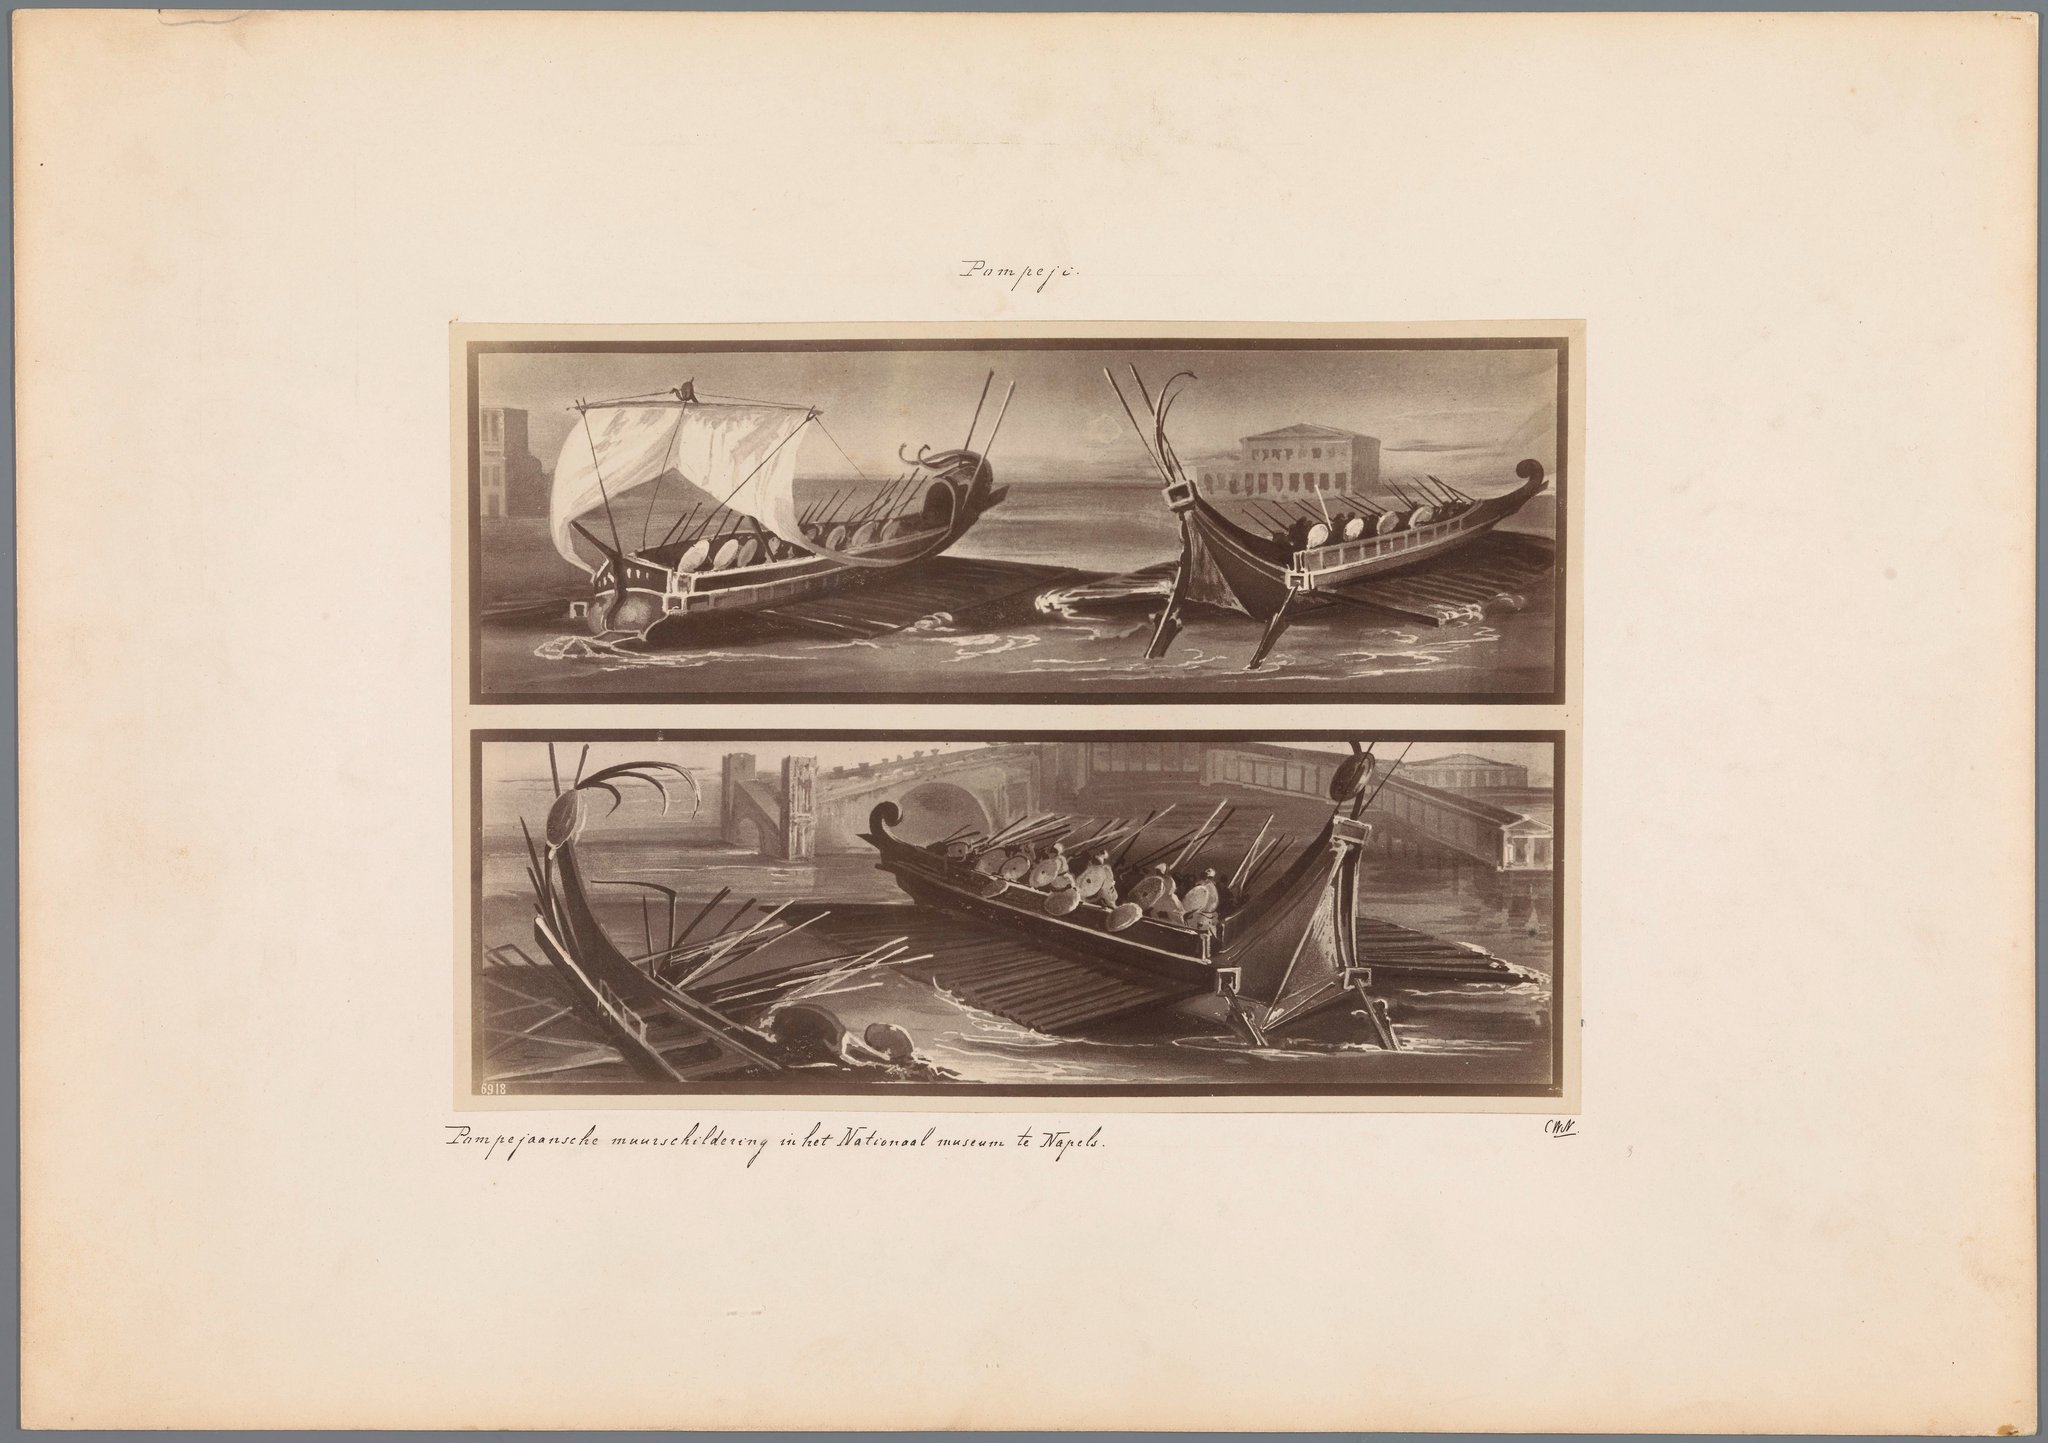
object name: photograph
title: Pompejaansche muurschilderingen in het Nationaal museum te Napels.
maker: Anonymous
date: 1875-1900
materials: cardboard, photographic support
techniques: albumen print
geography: europe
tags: sailing-ship, sailing-boat, painting (including book-illumination, miniature-painting) (+ plaster ~ arts), war, pompeii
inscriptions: inscription: ‘Pompeji.’, collector's mark: ‘INSTITUUT VOOR KUNST-NIJVERHEIDSONDERWIJS GABRIËL METSUSTRAAT No. 16 AMSTERDAM’, inscription: ‘CWN.’, number: ‘6918’, collector's mark: ‘KUNSTNIJVERHEIDSCHOOL QUELLINUS AMSTERDAM FRANS HALSSTRAAT 14.’